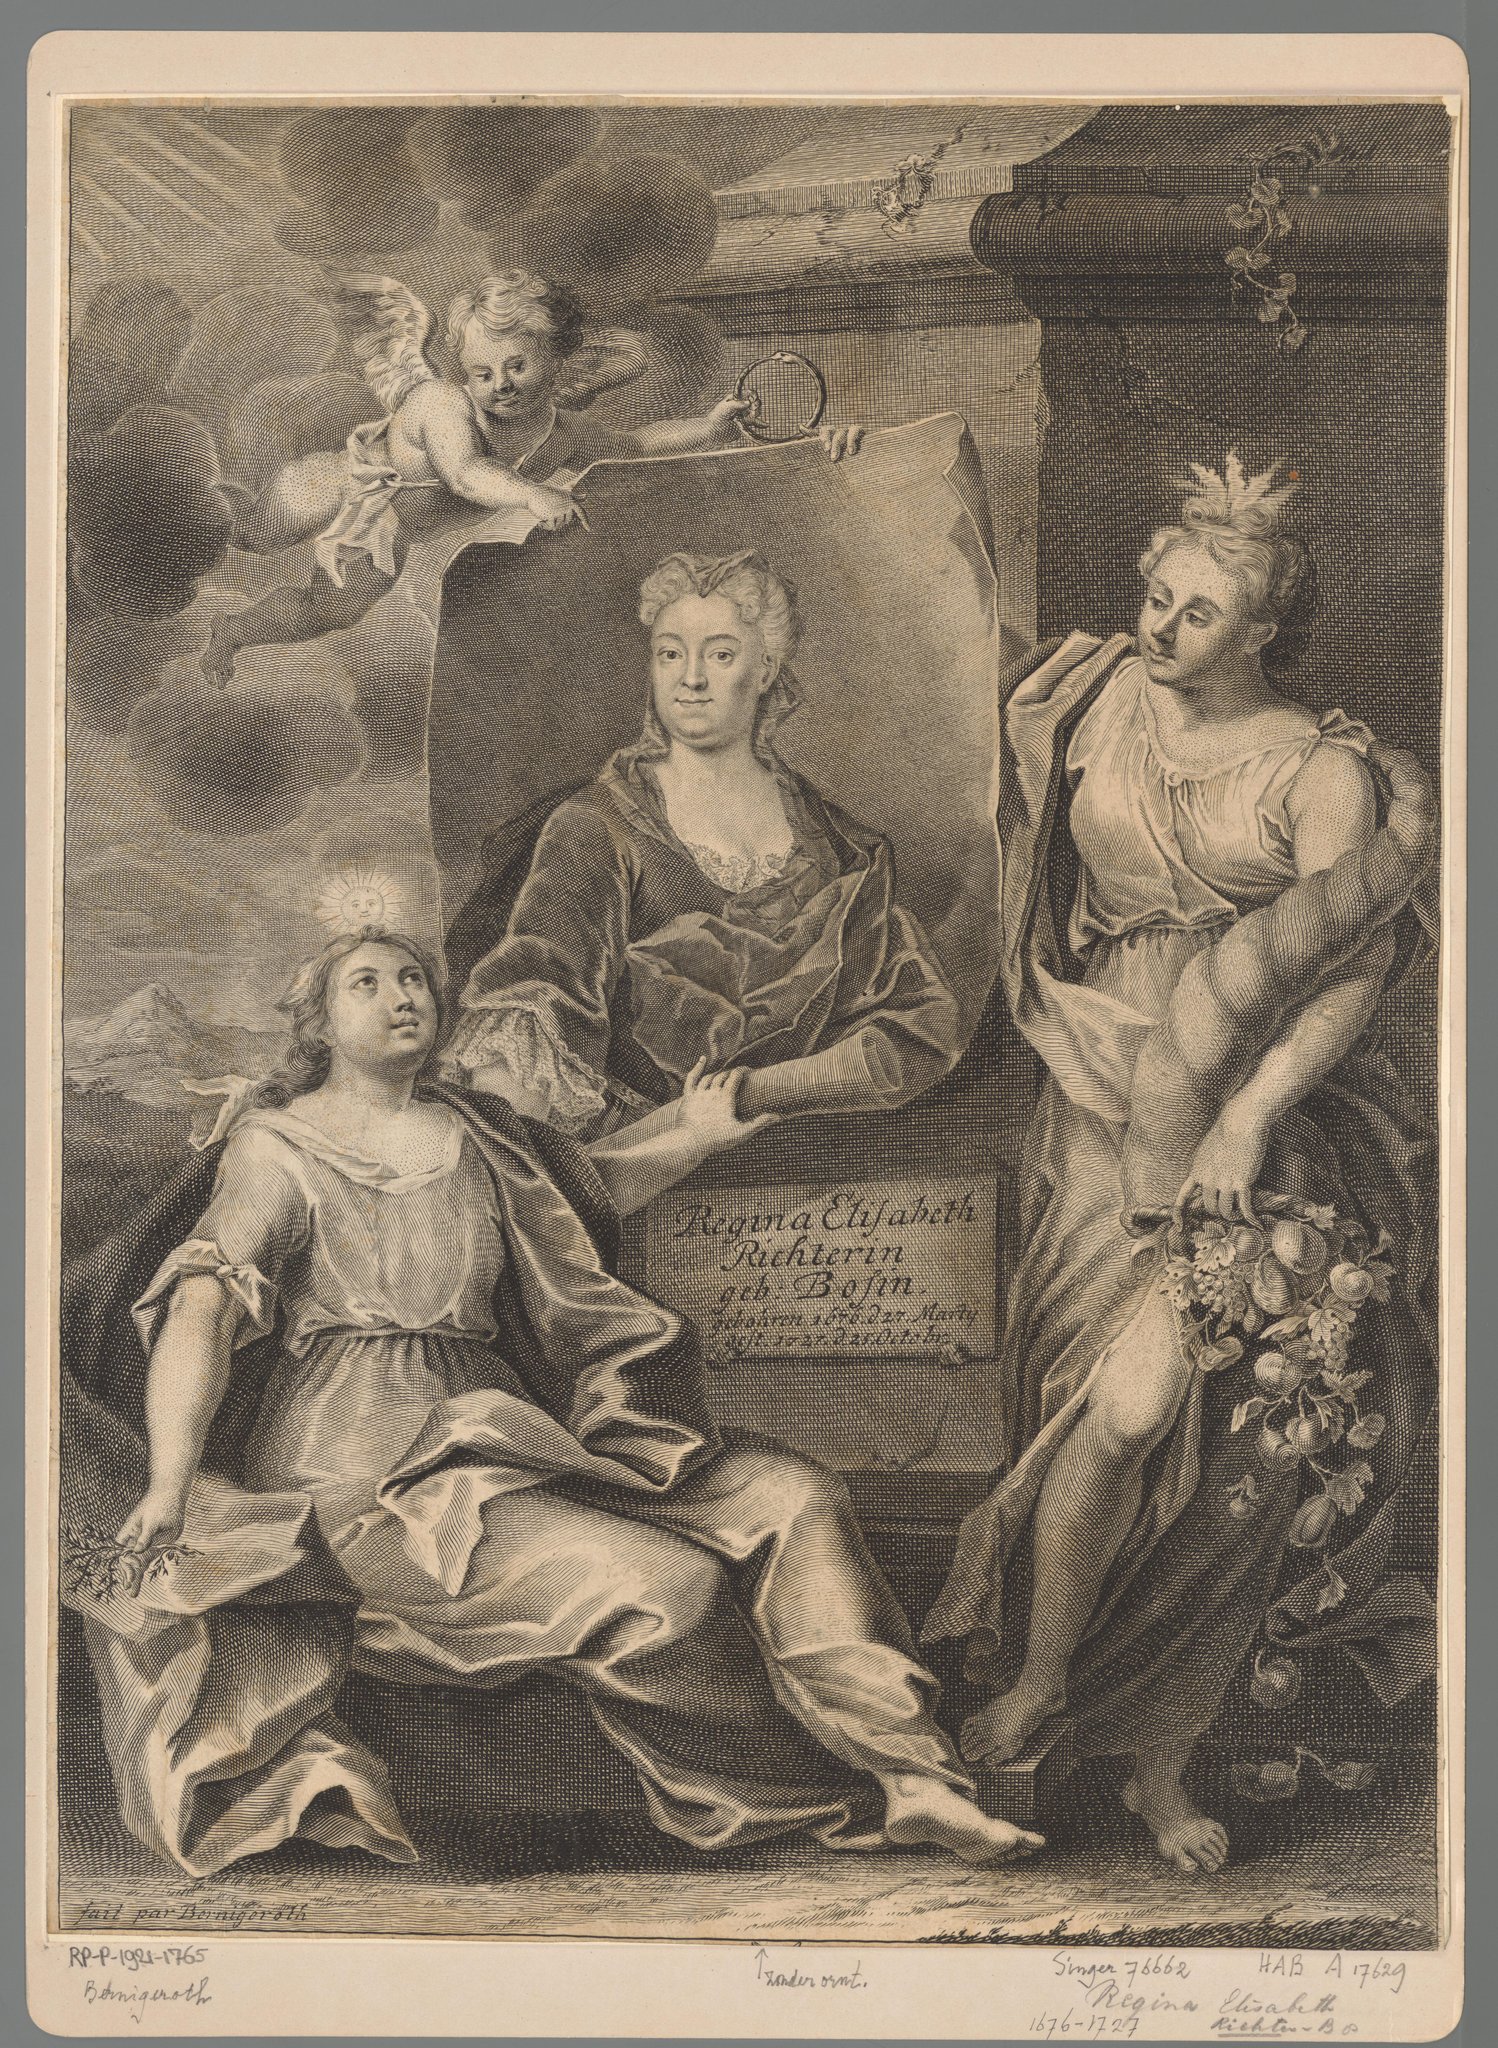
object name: print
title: Portret van Regina Elisabeth Richter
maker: johann martin bernigeroth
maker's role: print maker, publisher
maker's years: 1713-1767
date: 1727-1767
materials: paper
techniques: engraving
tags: historical persons - bb - woman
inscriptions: collector's mark: Lugt 2233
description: Een putto wijst naar het portret. Naast het portret Fortuna en Veritas.